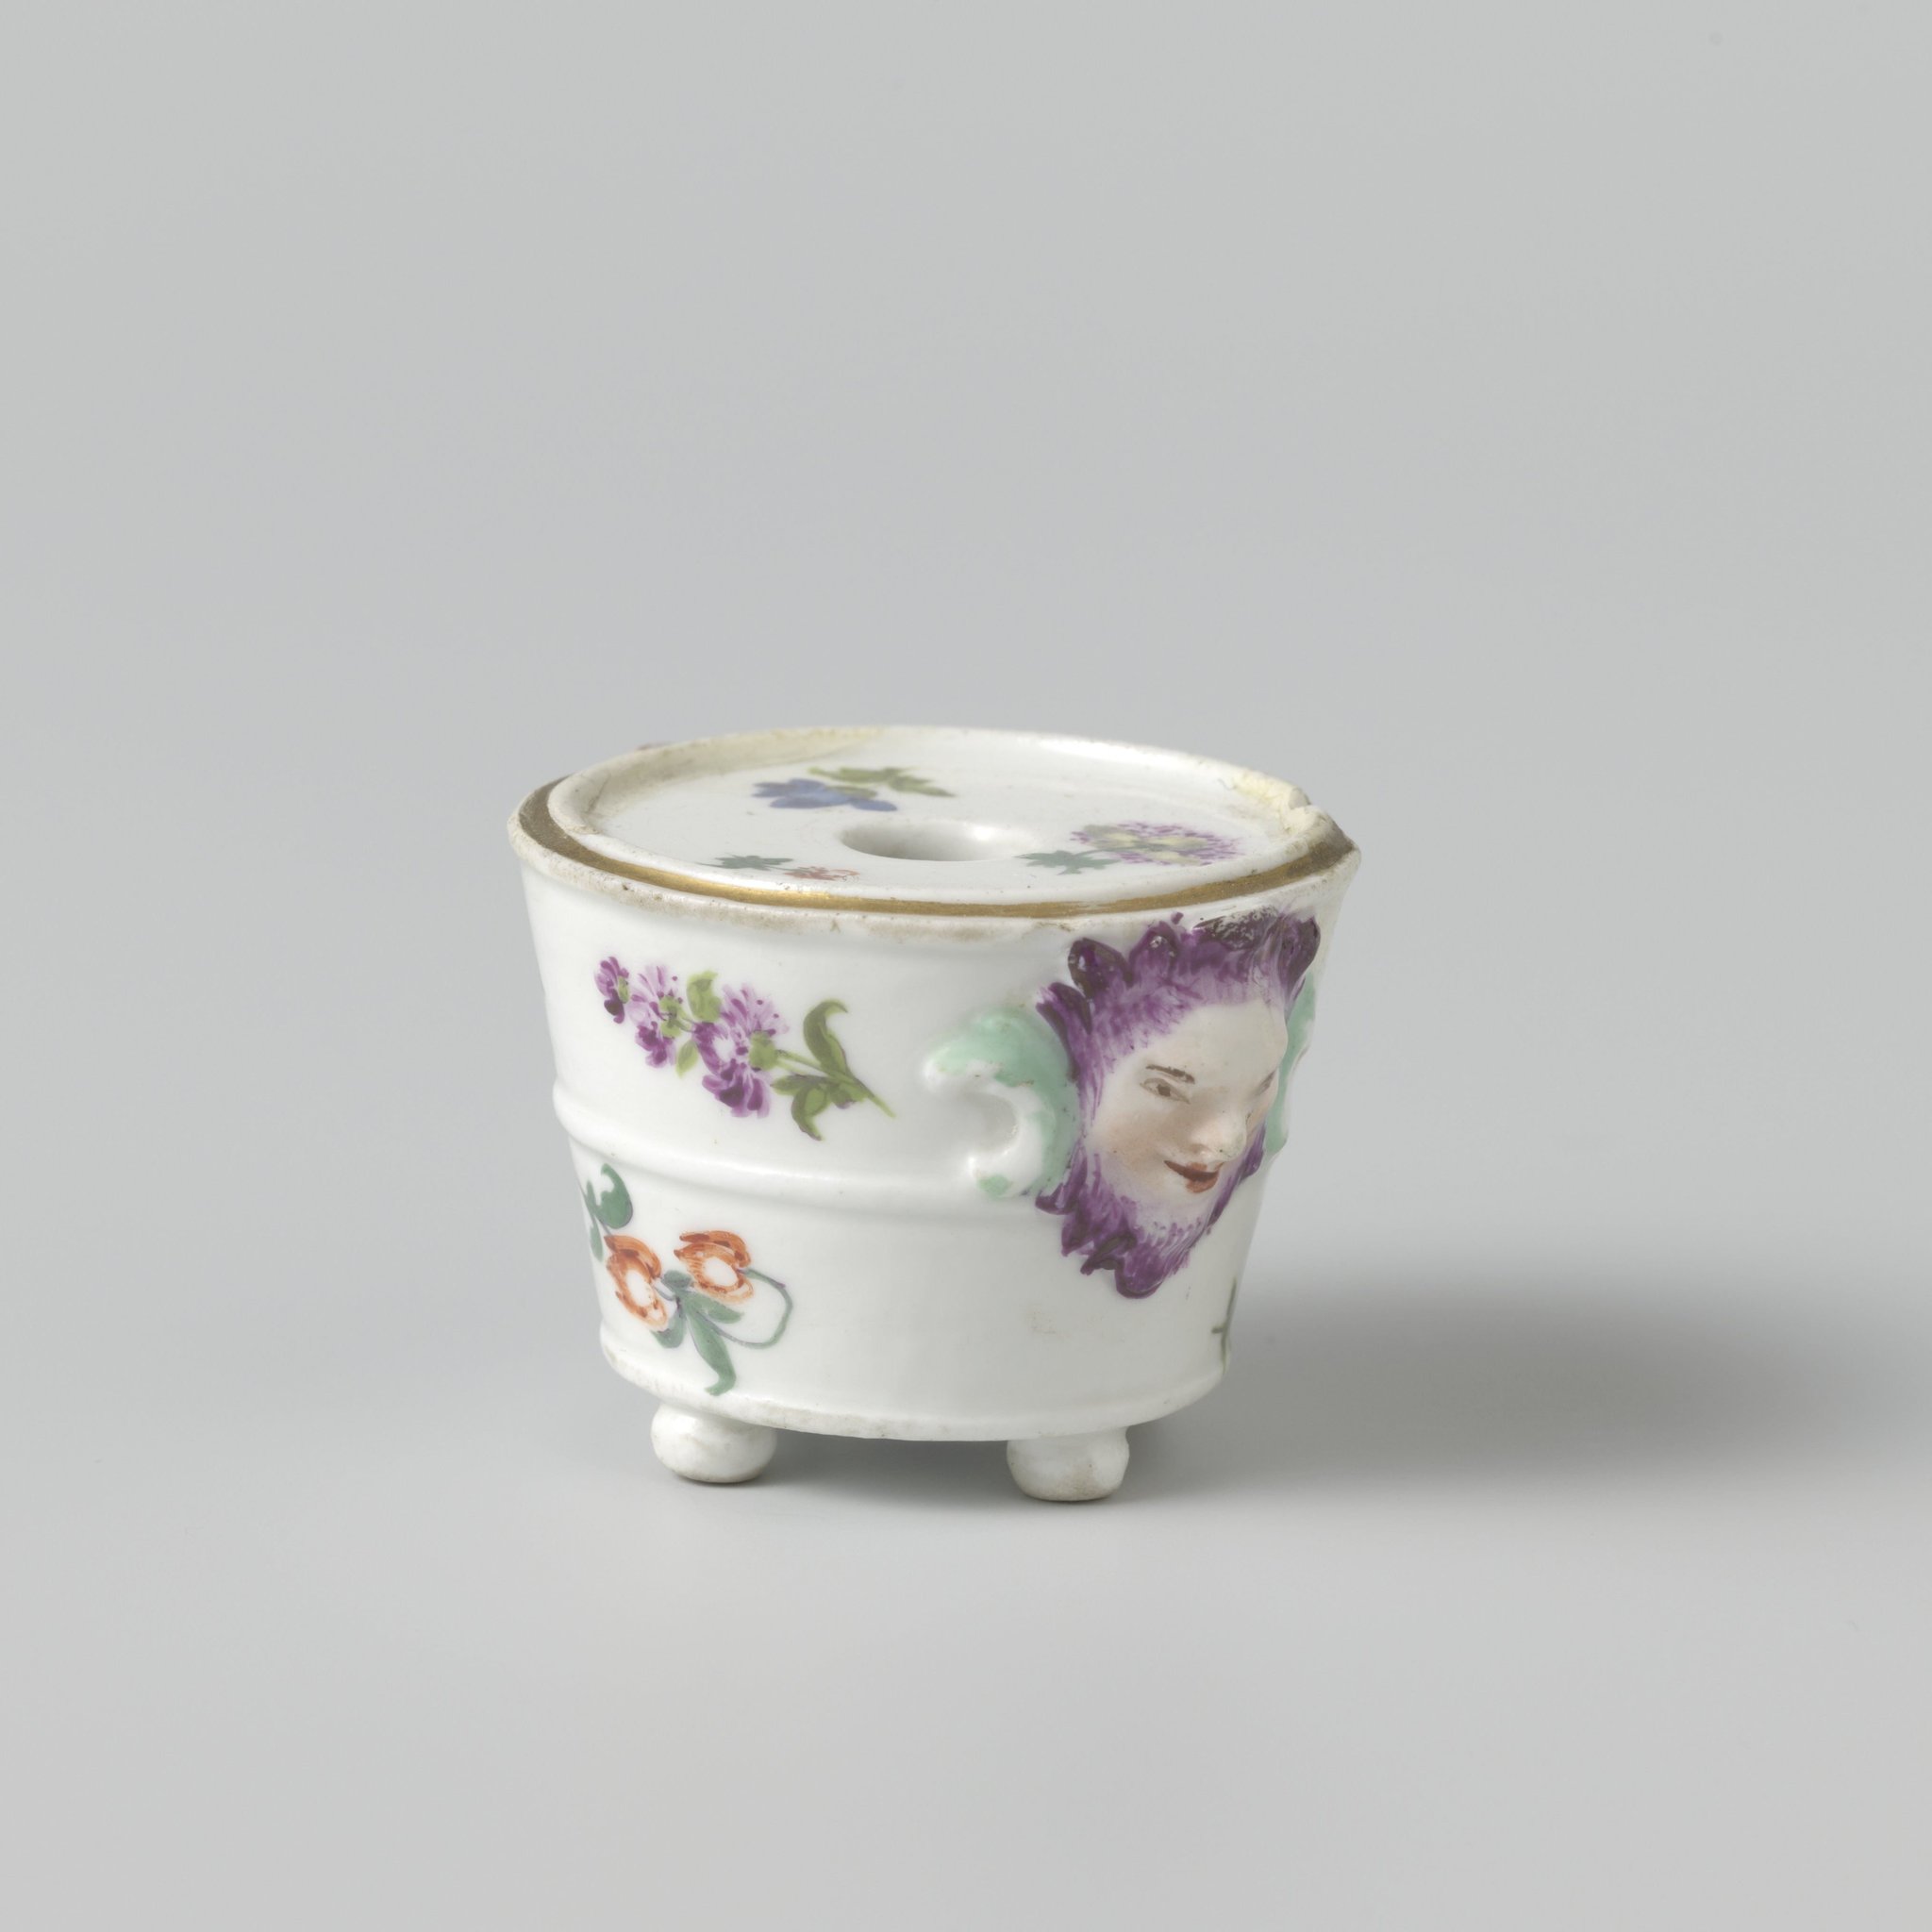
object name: flowerpot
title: Bloempot, veelkleurig beschilderd met bloemen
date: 1750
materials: porcelain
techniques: painted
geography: meissen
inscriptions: factory mark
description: Bloempot van beschilderd porselein. De pot is bekervormig en staat op vier bolvormige poten. De pot is versierd met twee maskers in reliëf en is beschilderd met veelkleurige bloemen. De bloempot is gemerkt.